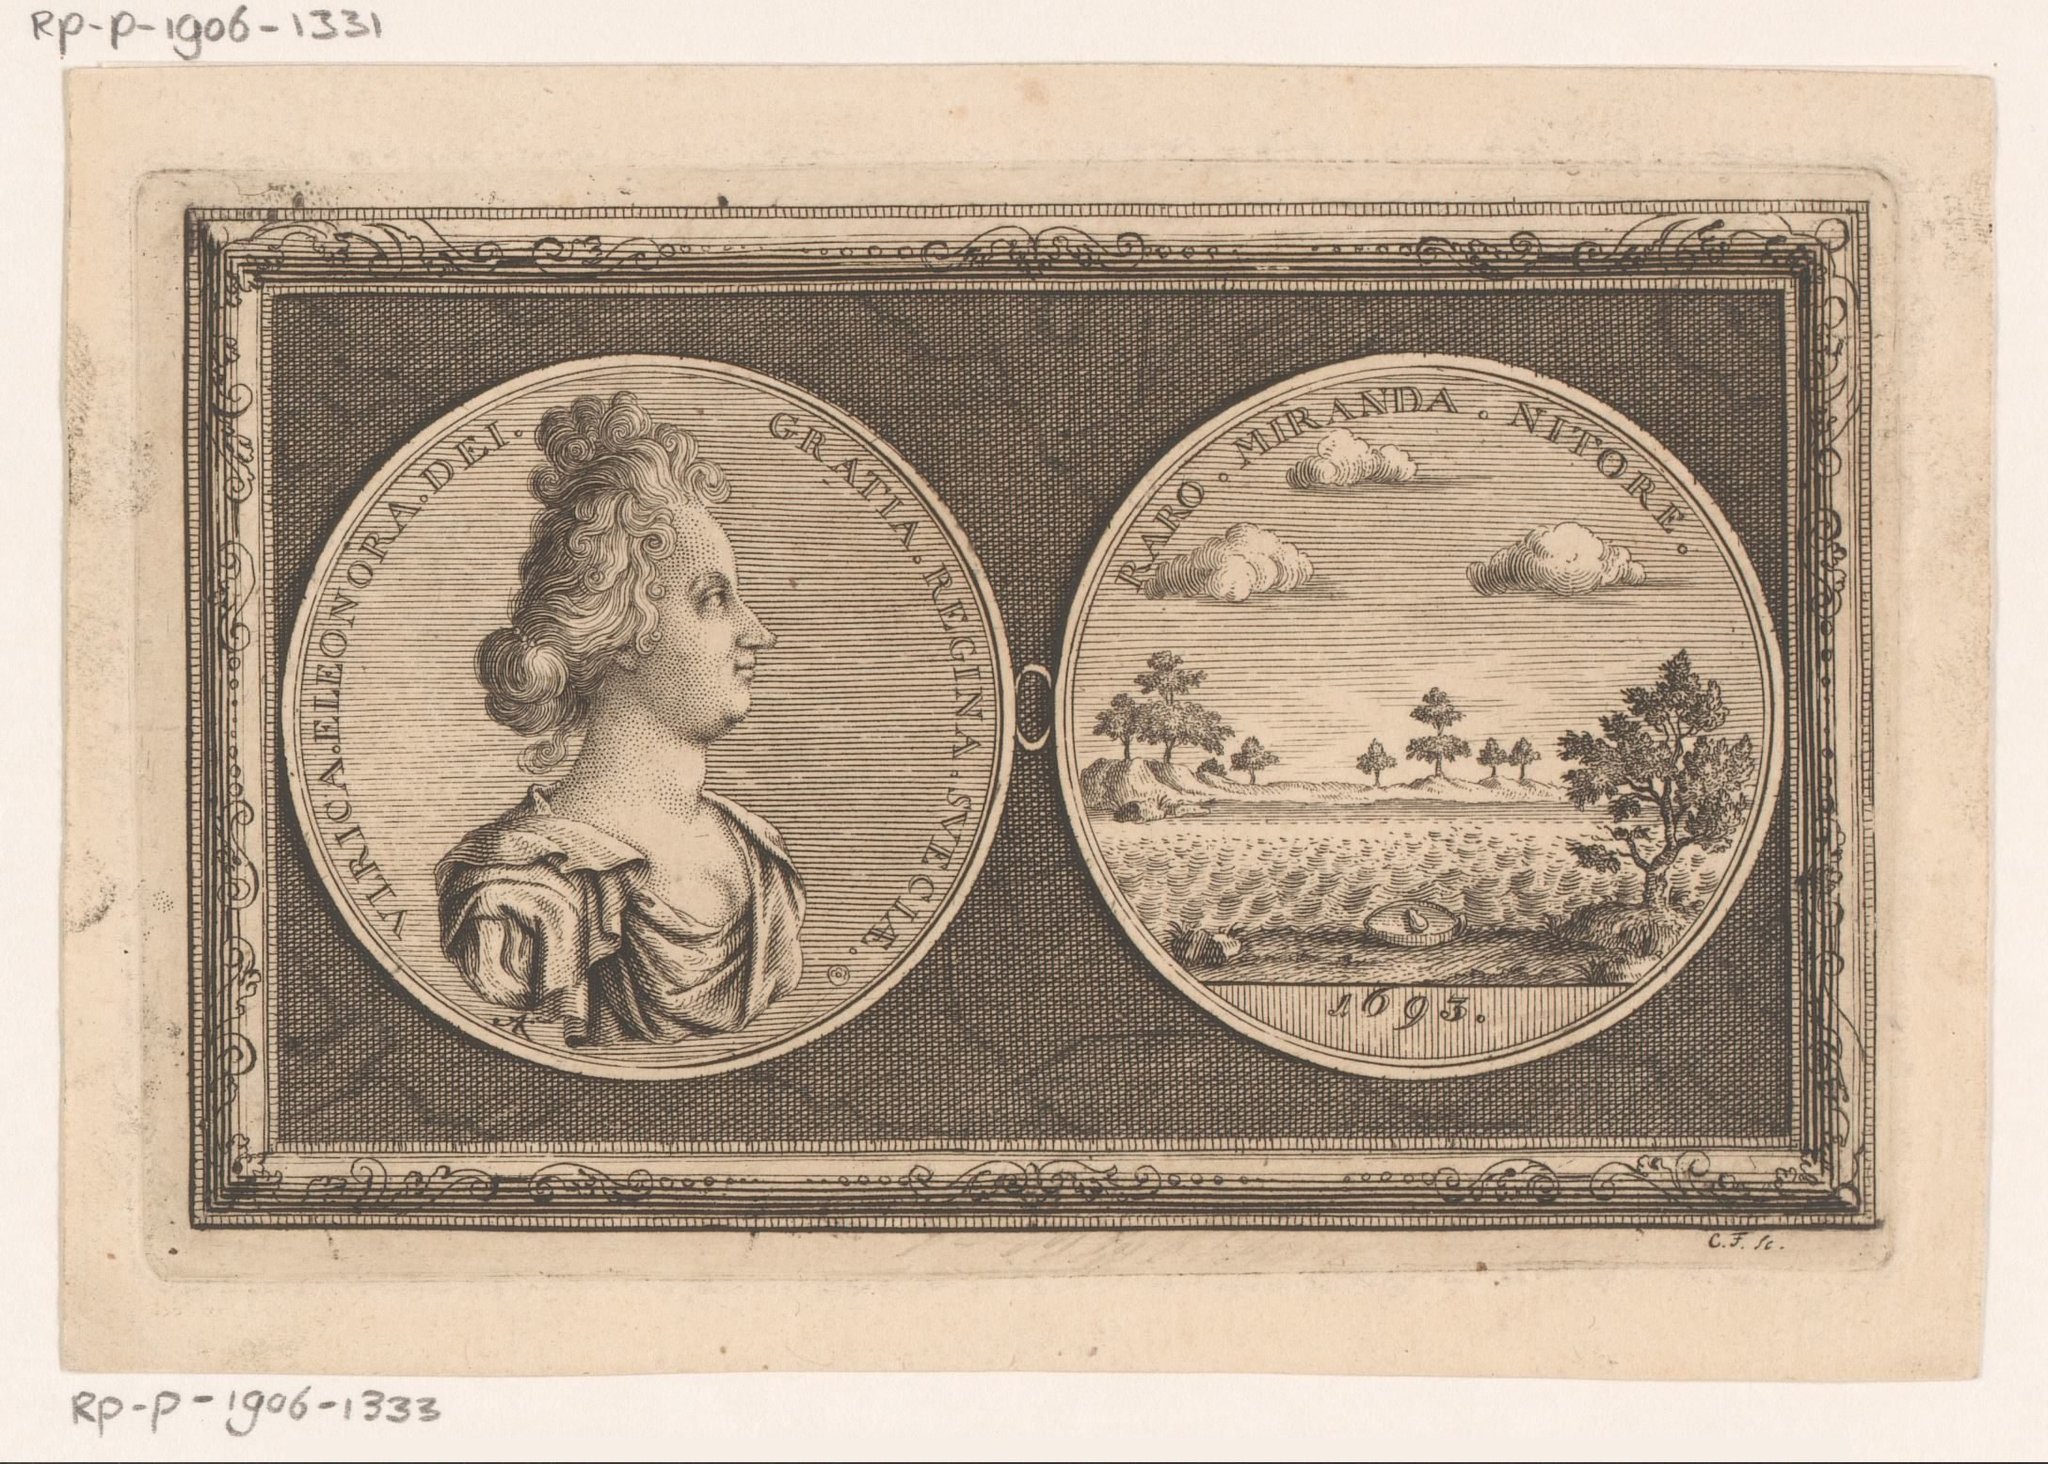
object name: print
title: Medaille met het portret van Ulrika Eleonora en tegenzijde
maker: christian fritzsch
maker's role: print maker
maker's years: 1695-1769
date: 1705-1769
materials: paper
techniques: engraving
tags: historical persons - bb - woman, ruler, sovereign - bb - female ruler, medal (considered as a piece of sculpture, regardless of its specific function), abstract ideas and concepts (+ emblematical representation of concept), mortality, extinction of life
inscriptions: collector's mark: Lugt 2228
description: Gedecoreerde lijst met links het portret van Ulrika Eleonora en rechts een emblematische allegorie op haar overlijden.